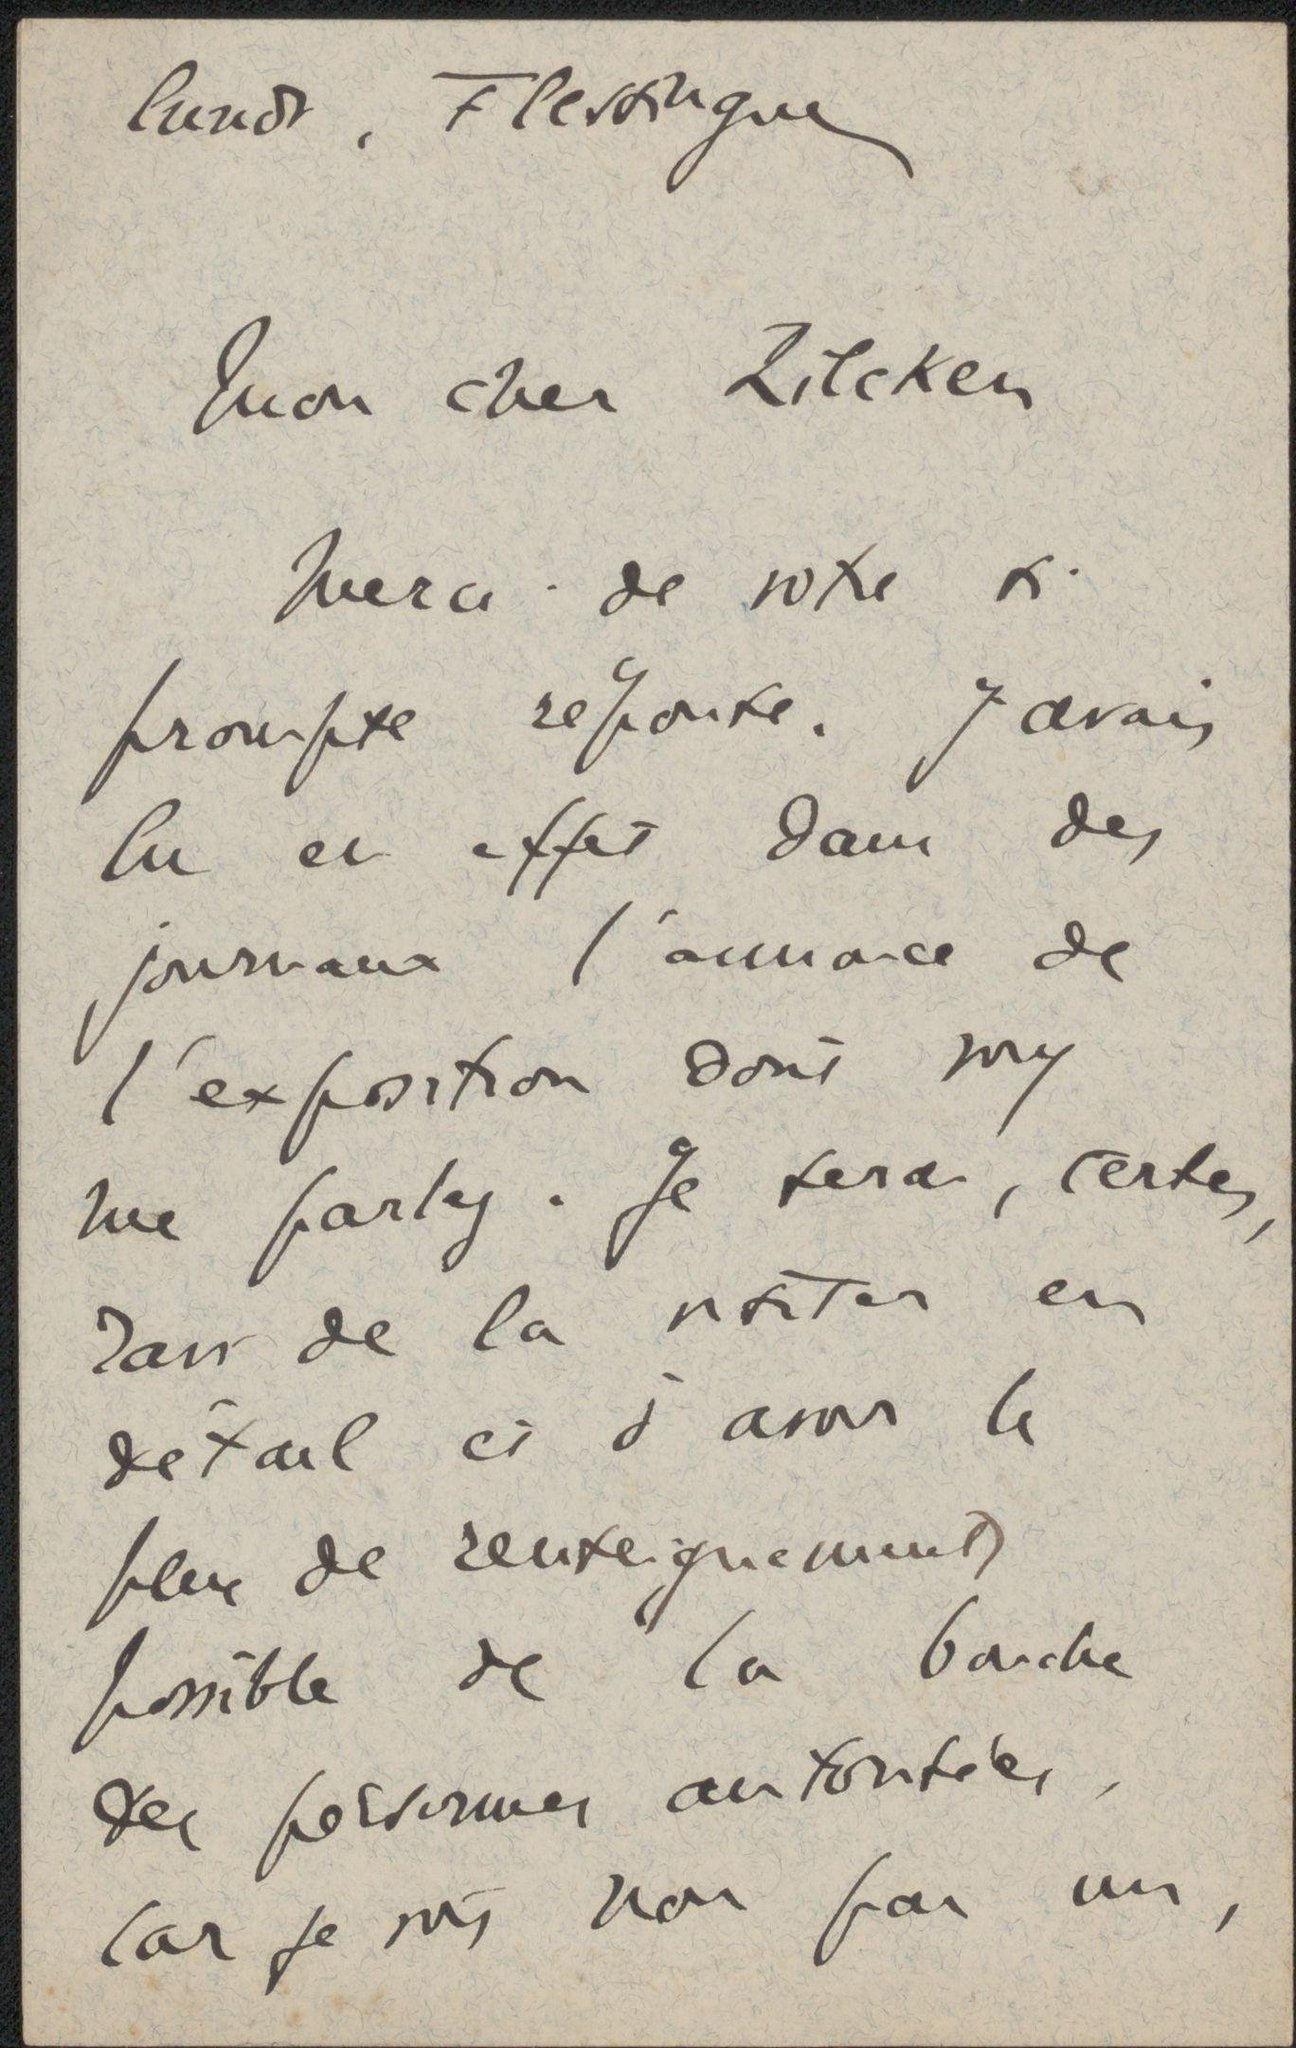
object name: letter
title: Brief aan Philip Zilcken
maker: gabriel mourey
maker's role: criticus, schrijver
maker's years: 1865-1943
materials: ink, paper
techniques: pen, writing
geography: flushing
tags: ghent, print maker, draughtsman, albert baertsoen, philip zilcken, exhibition ~ art, printed matter, the hague, dordrecht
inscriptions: collector's mark: ‘RPK’